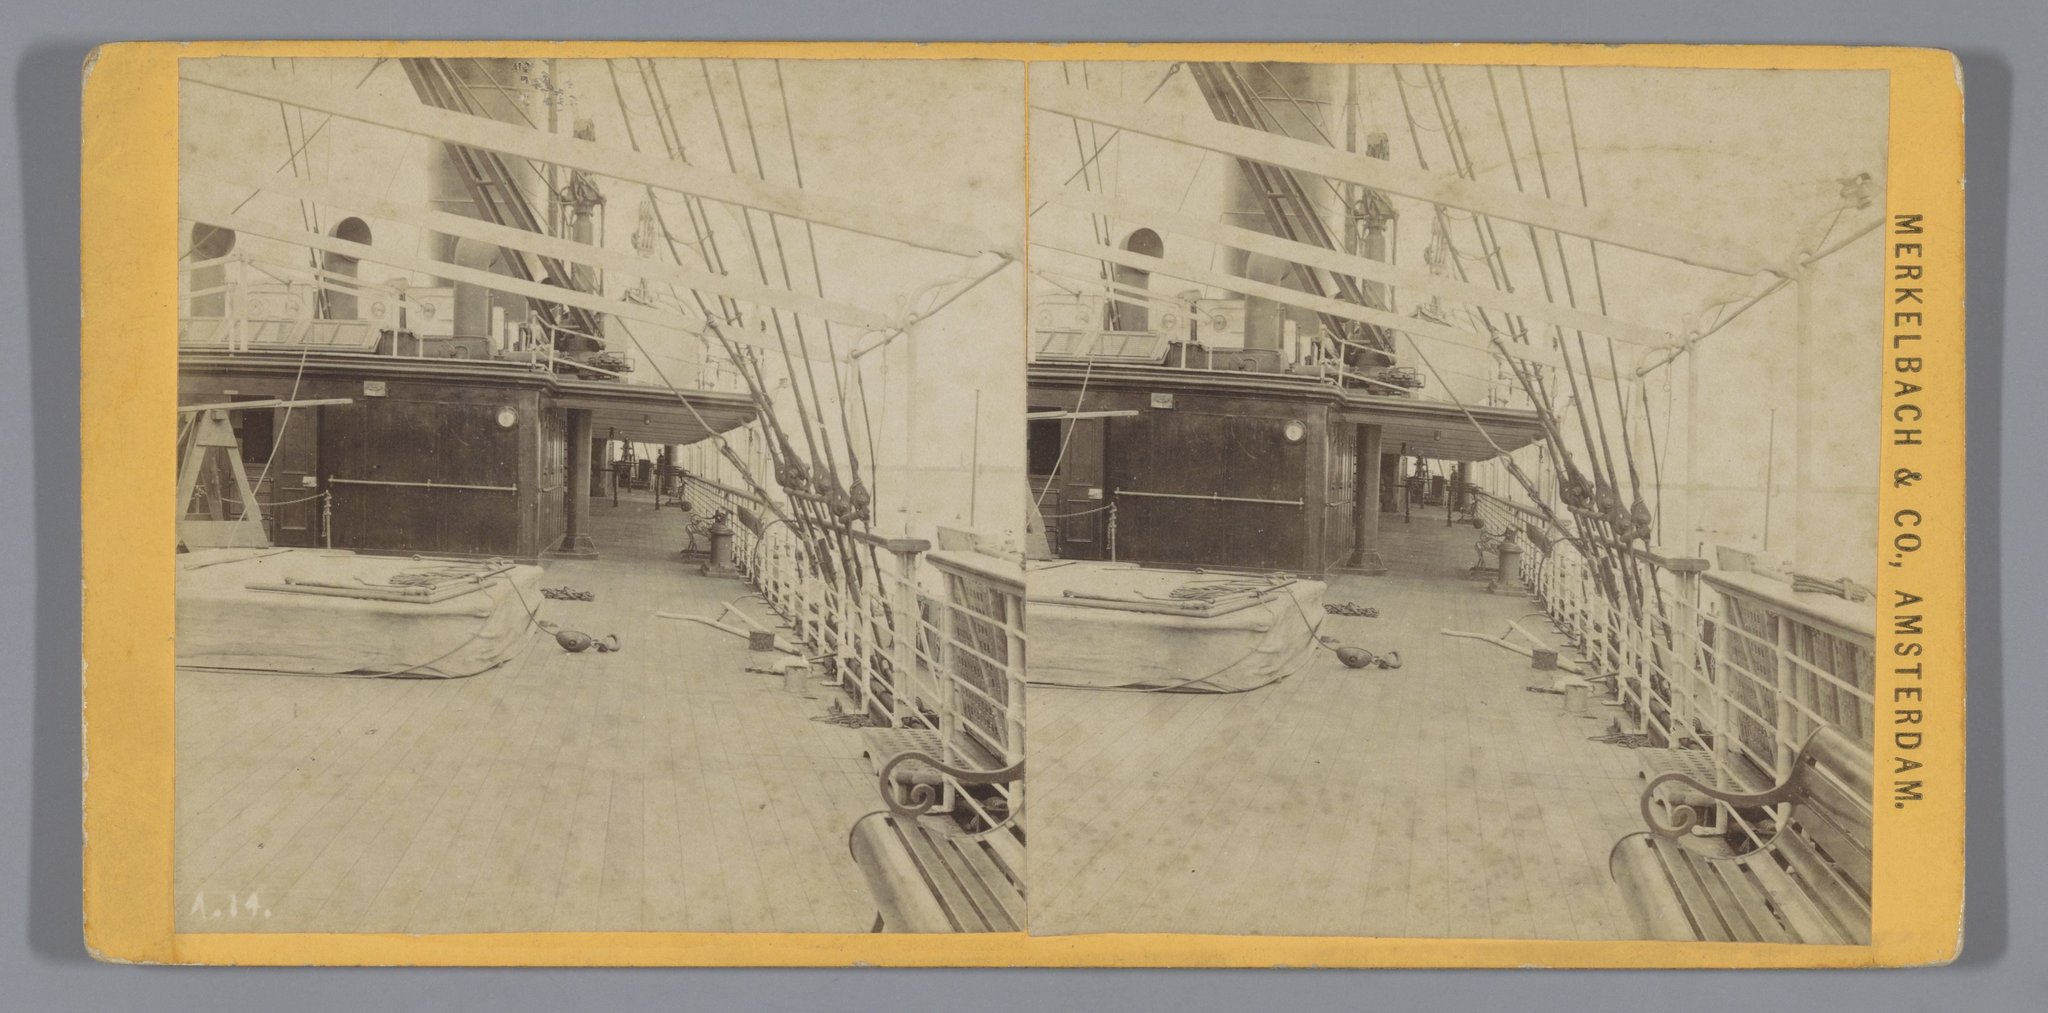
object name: stereograph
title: Aardrijkskundige beeldengalerij, verzameld door M.J. Broekhuijsen, hoofd eener school te Amsterdam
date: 1900-1902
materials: cardboard, paper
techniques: albumen print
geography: amsterdam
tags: parts of ship's exterior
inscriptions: inscription: ‘A.14.’, : ‘Het wandeldek van de "Koning Willem I" (...) eerste-klas-passagiers.’, number: ‘14.’